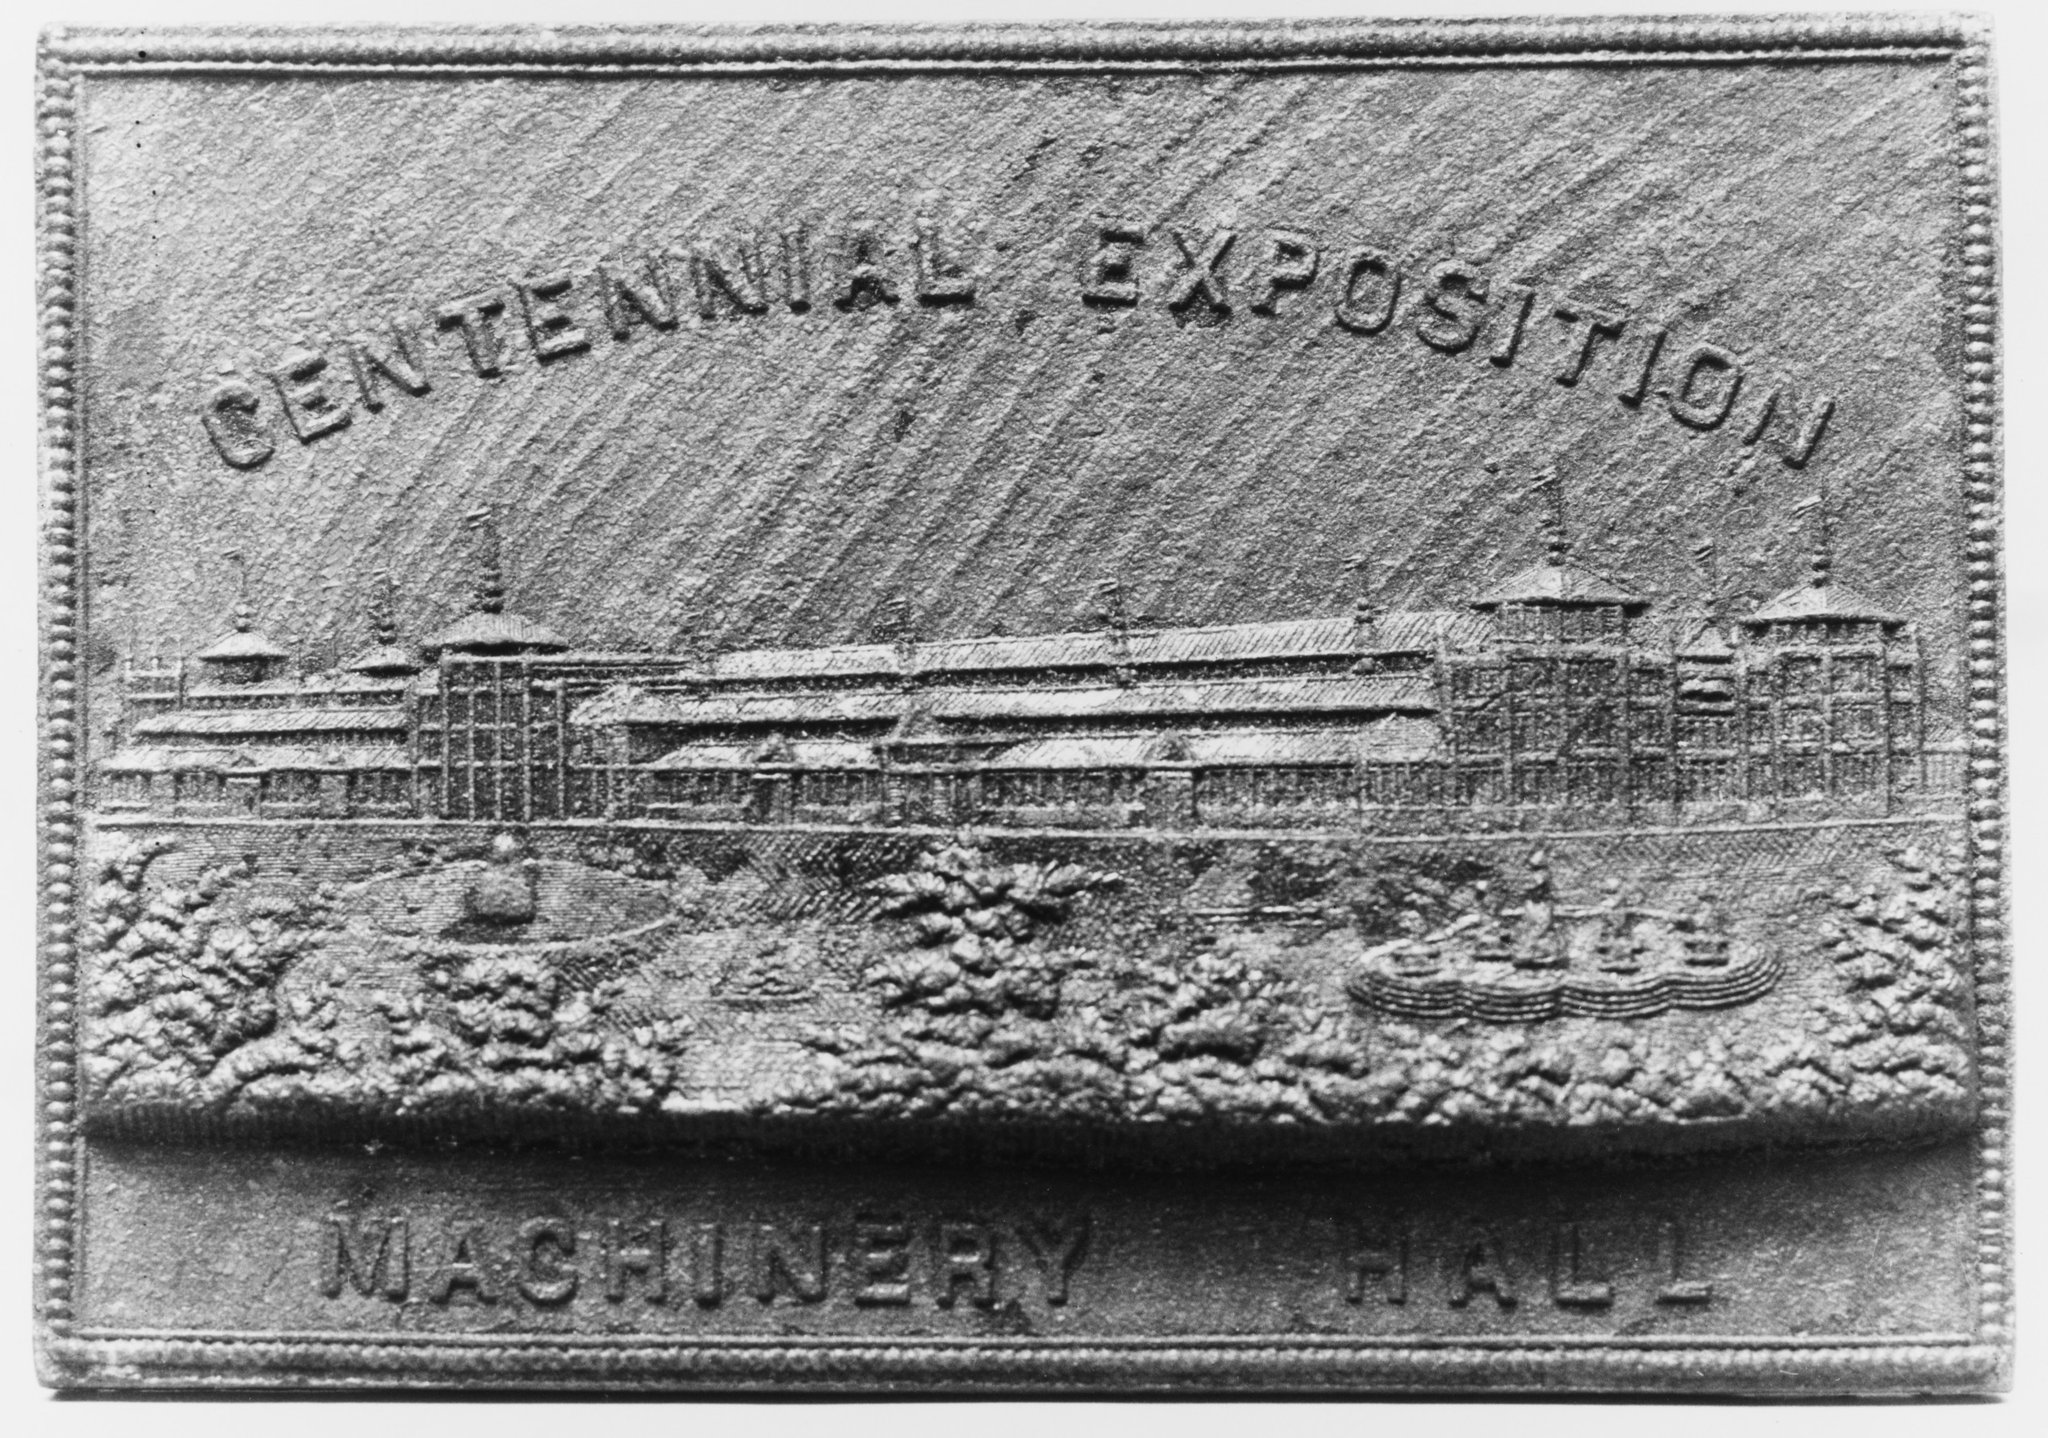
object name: plaque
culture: american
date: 1876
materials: wood